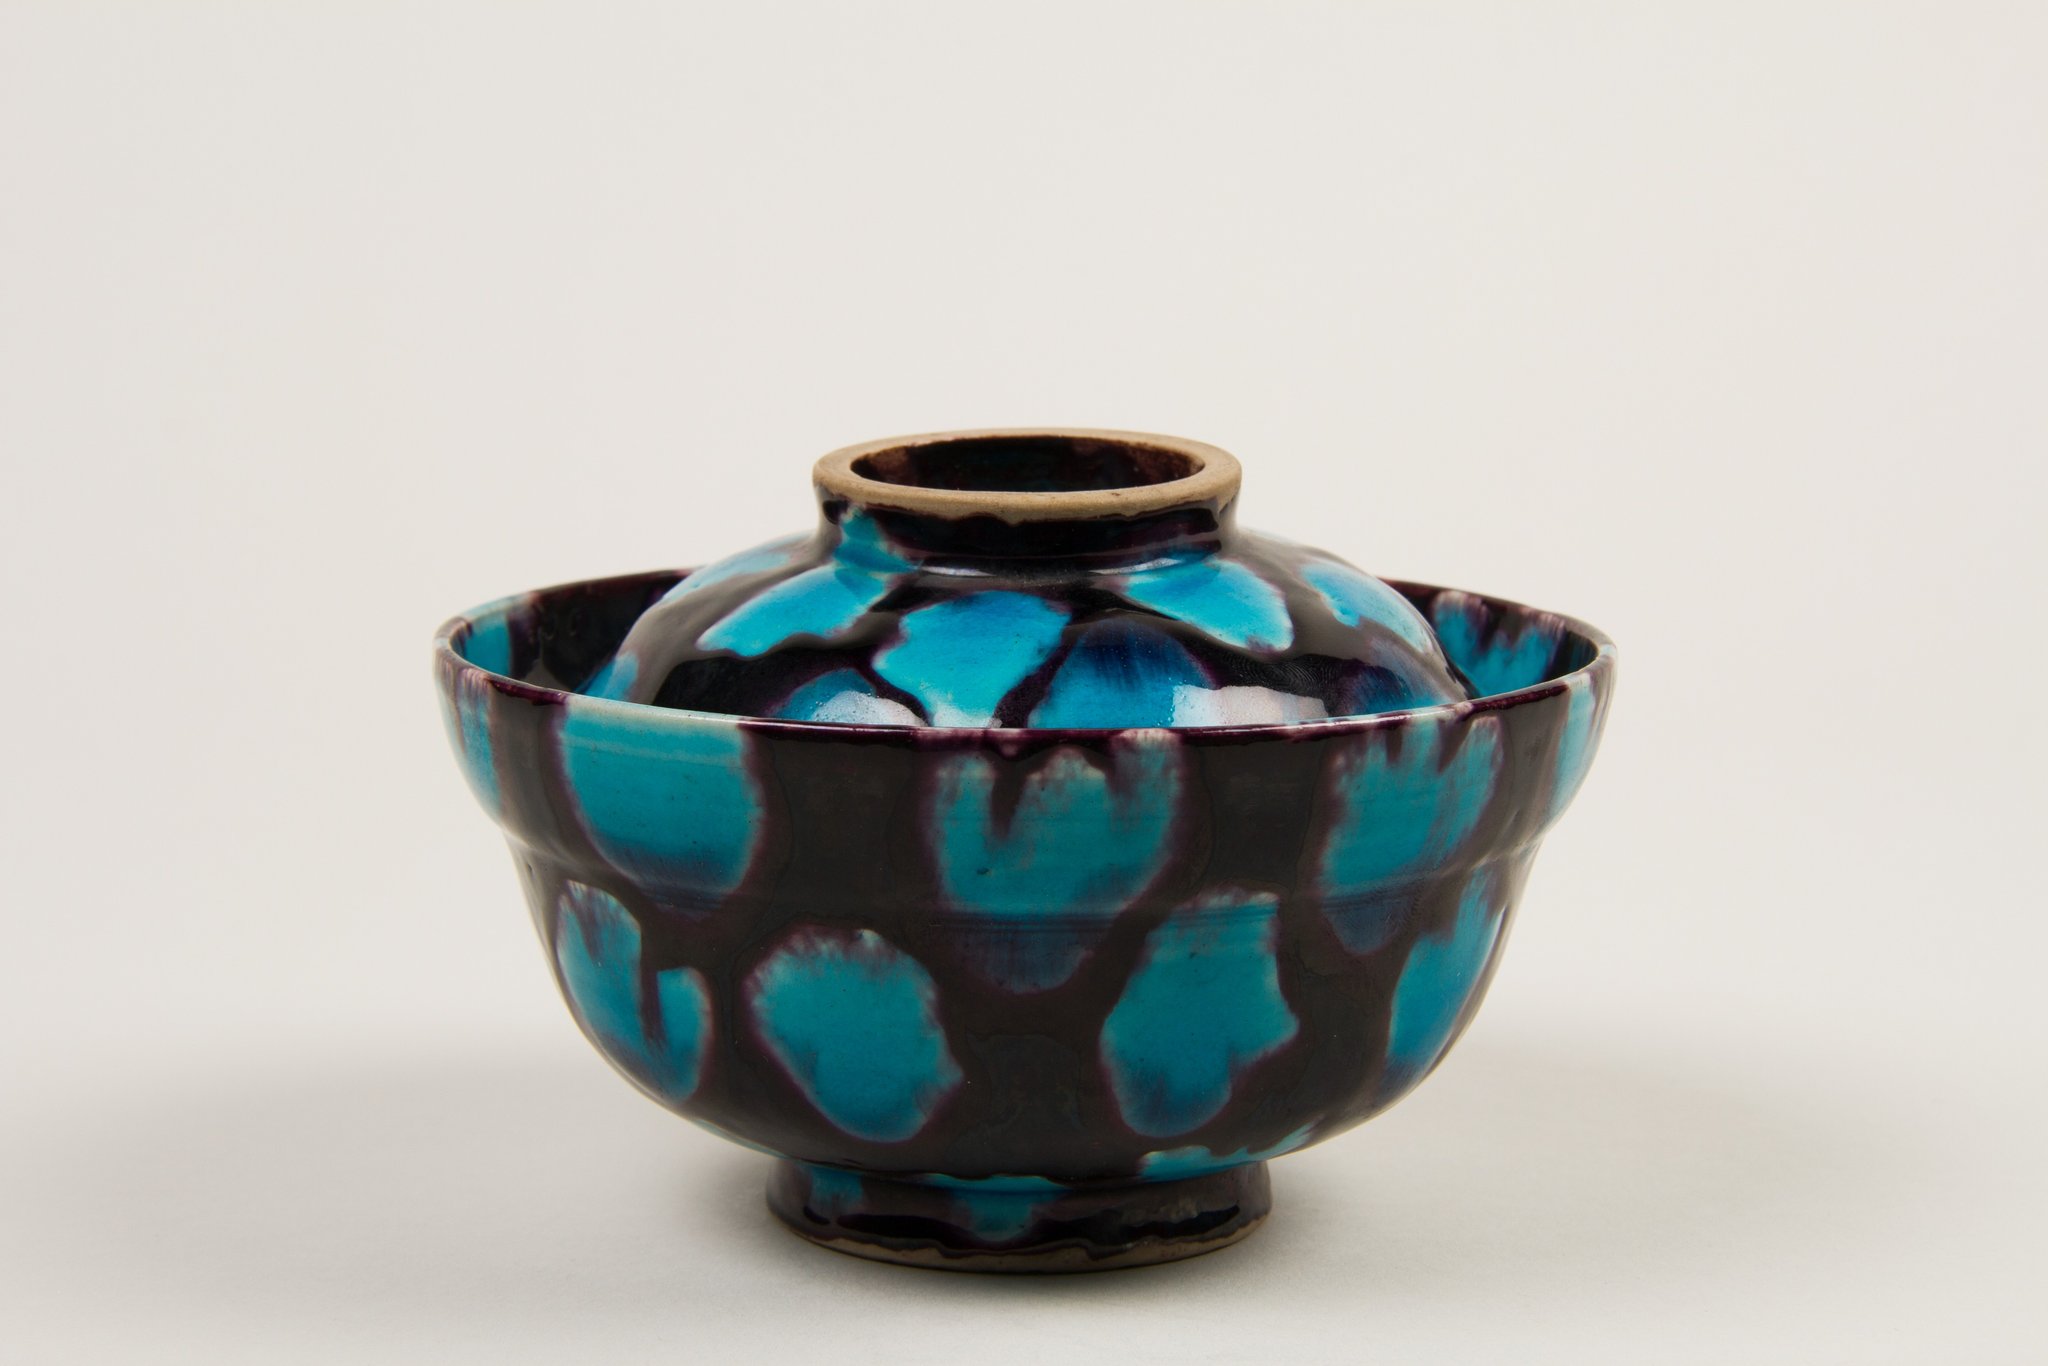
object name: covered bowl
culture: japanese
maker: eiraku hozen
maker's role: artist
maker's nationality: japanese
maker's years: 1795-1854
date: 1801-1900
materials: glaze, porcelain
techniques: polychrome